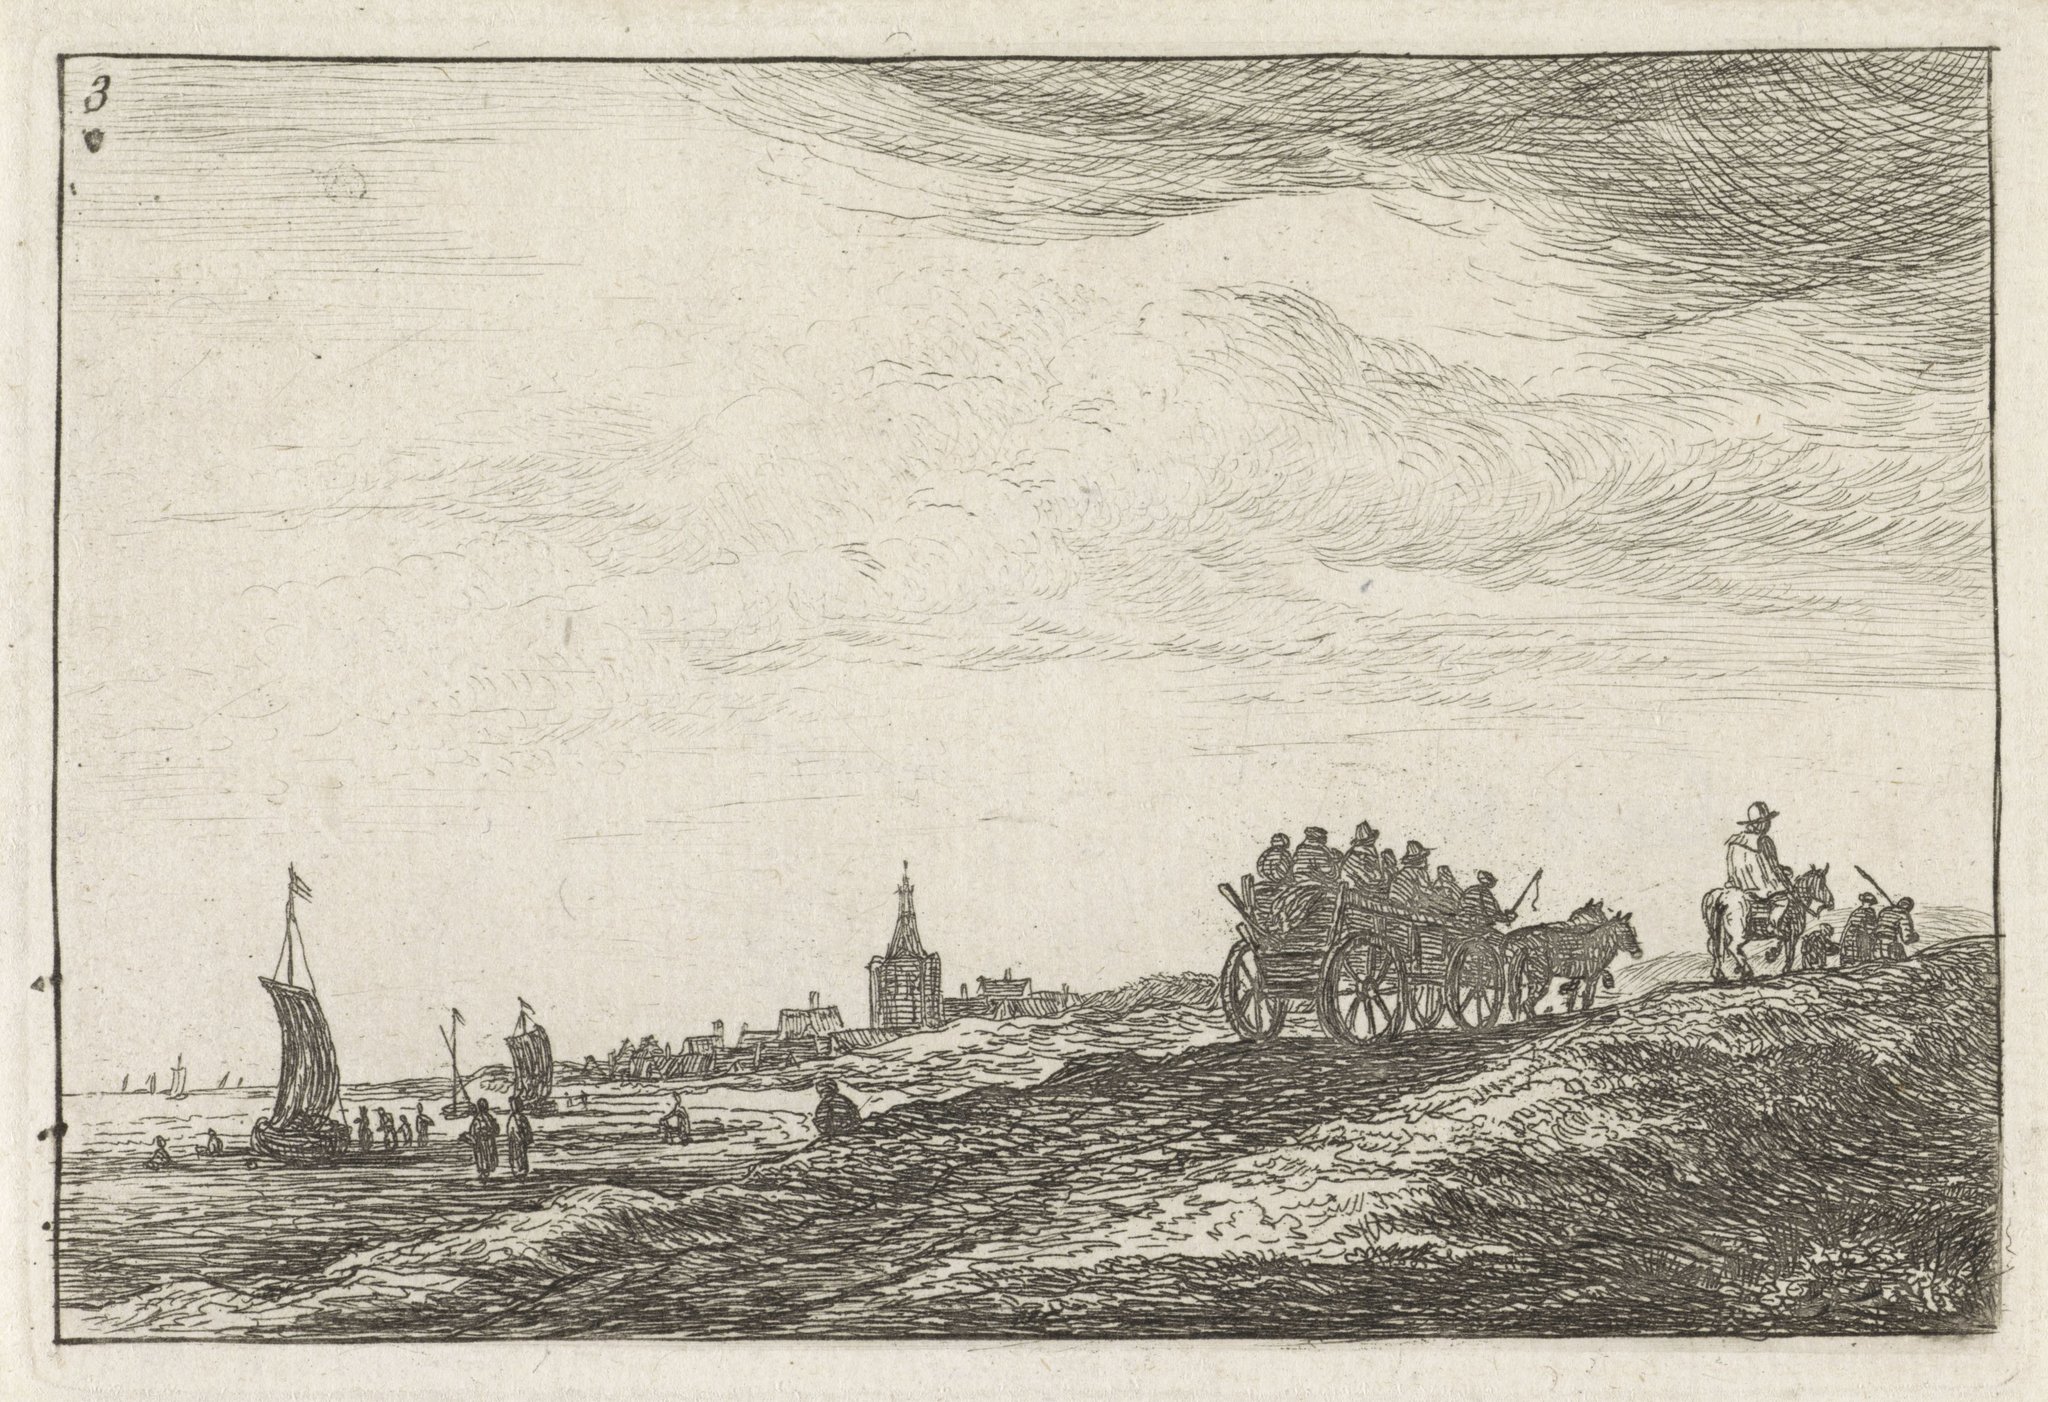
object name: print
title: Kustlijn met paard en wagen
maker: anthonie waterloo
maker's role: draughtsman, painter, print maker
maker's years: 1609-1690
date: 1630-1663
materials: paper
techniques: etching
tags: city-view, and landscape with man-made constructions, sailing-ship, sailing-boat, horse, coast, (farm) wagon, freight wagon, cart, sea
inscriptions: collector's mark: Lugt 2228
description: Links liggen enkele zeilschepen voor en op de kust, mogelijk te Scheveningen. Rechts rijdt een bemande kar met twee paarden achter een ruiter en enkele wandelaars. Links in de verte ligt een dorp of stad met een kerktoren.